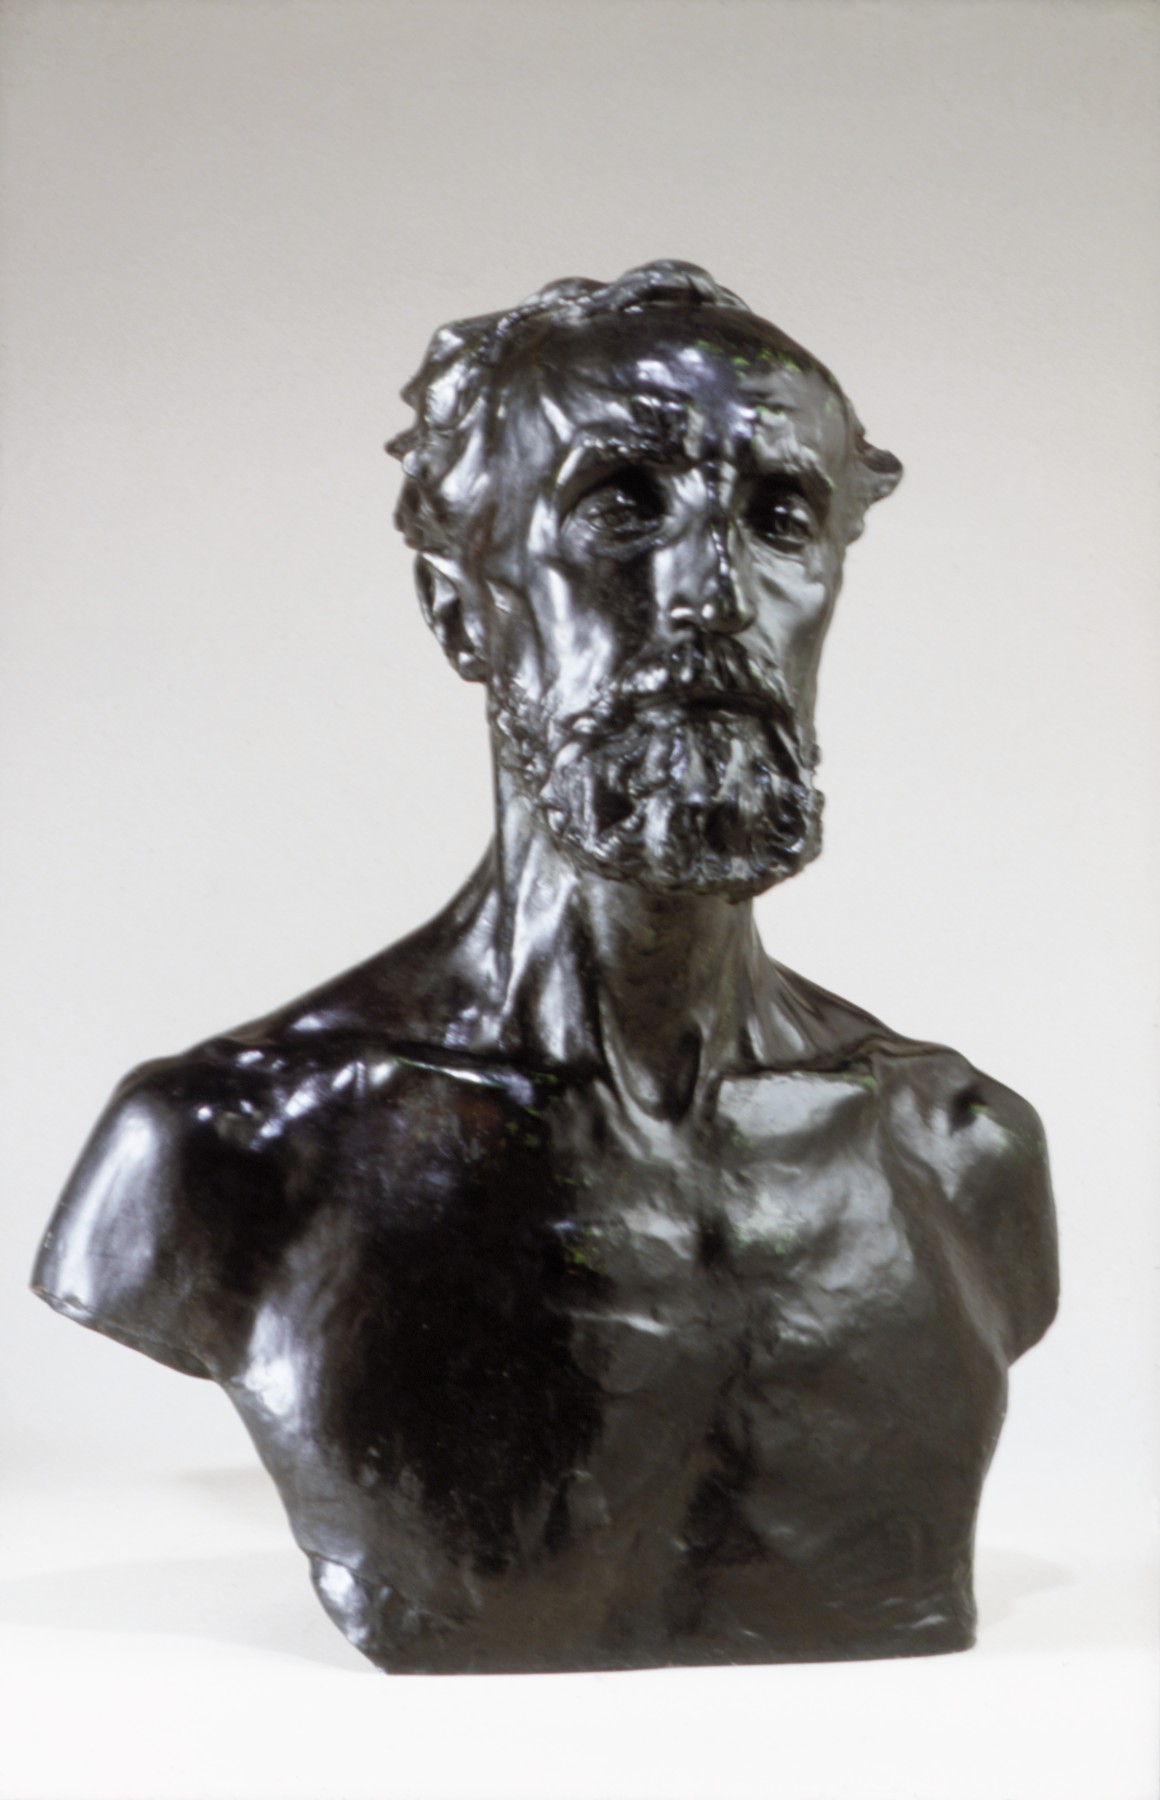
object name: bust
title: Jules Dalou (1838–1902)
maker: auguste rodin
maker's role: artist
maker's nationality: french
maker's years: 1840-1917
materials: bronze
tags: men,portraits